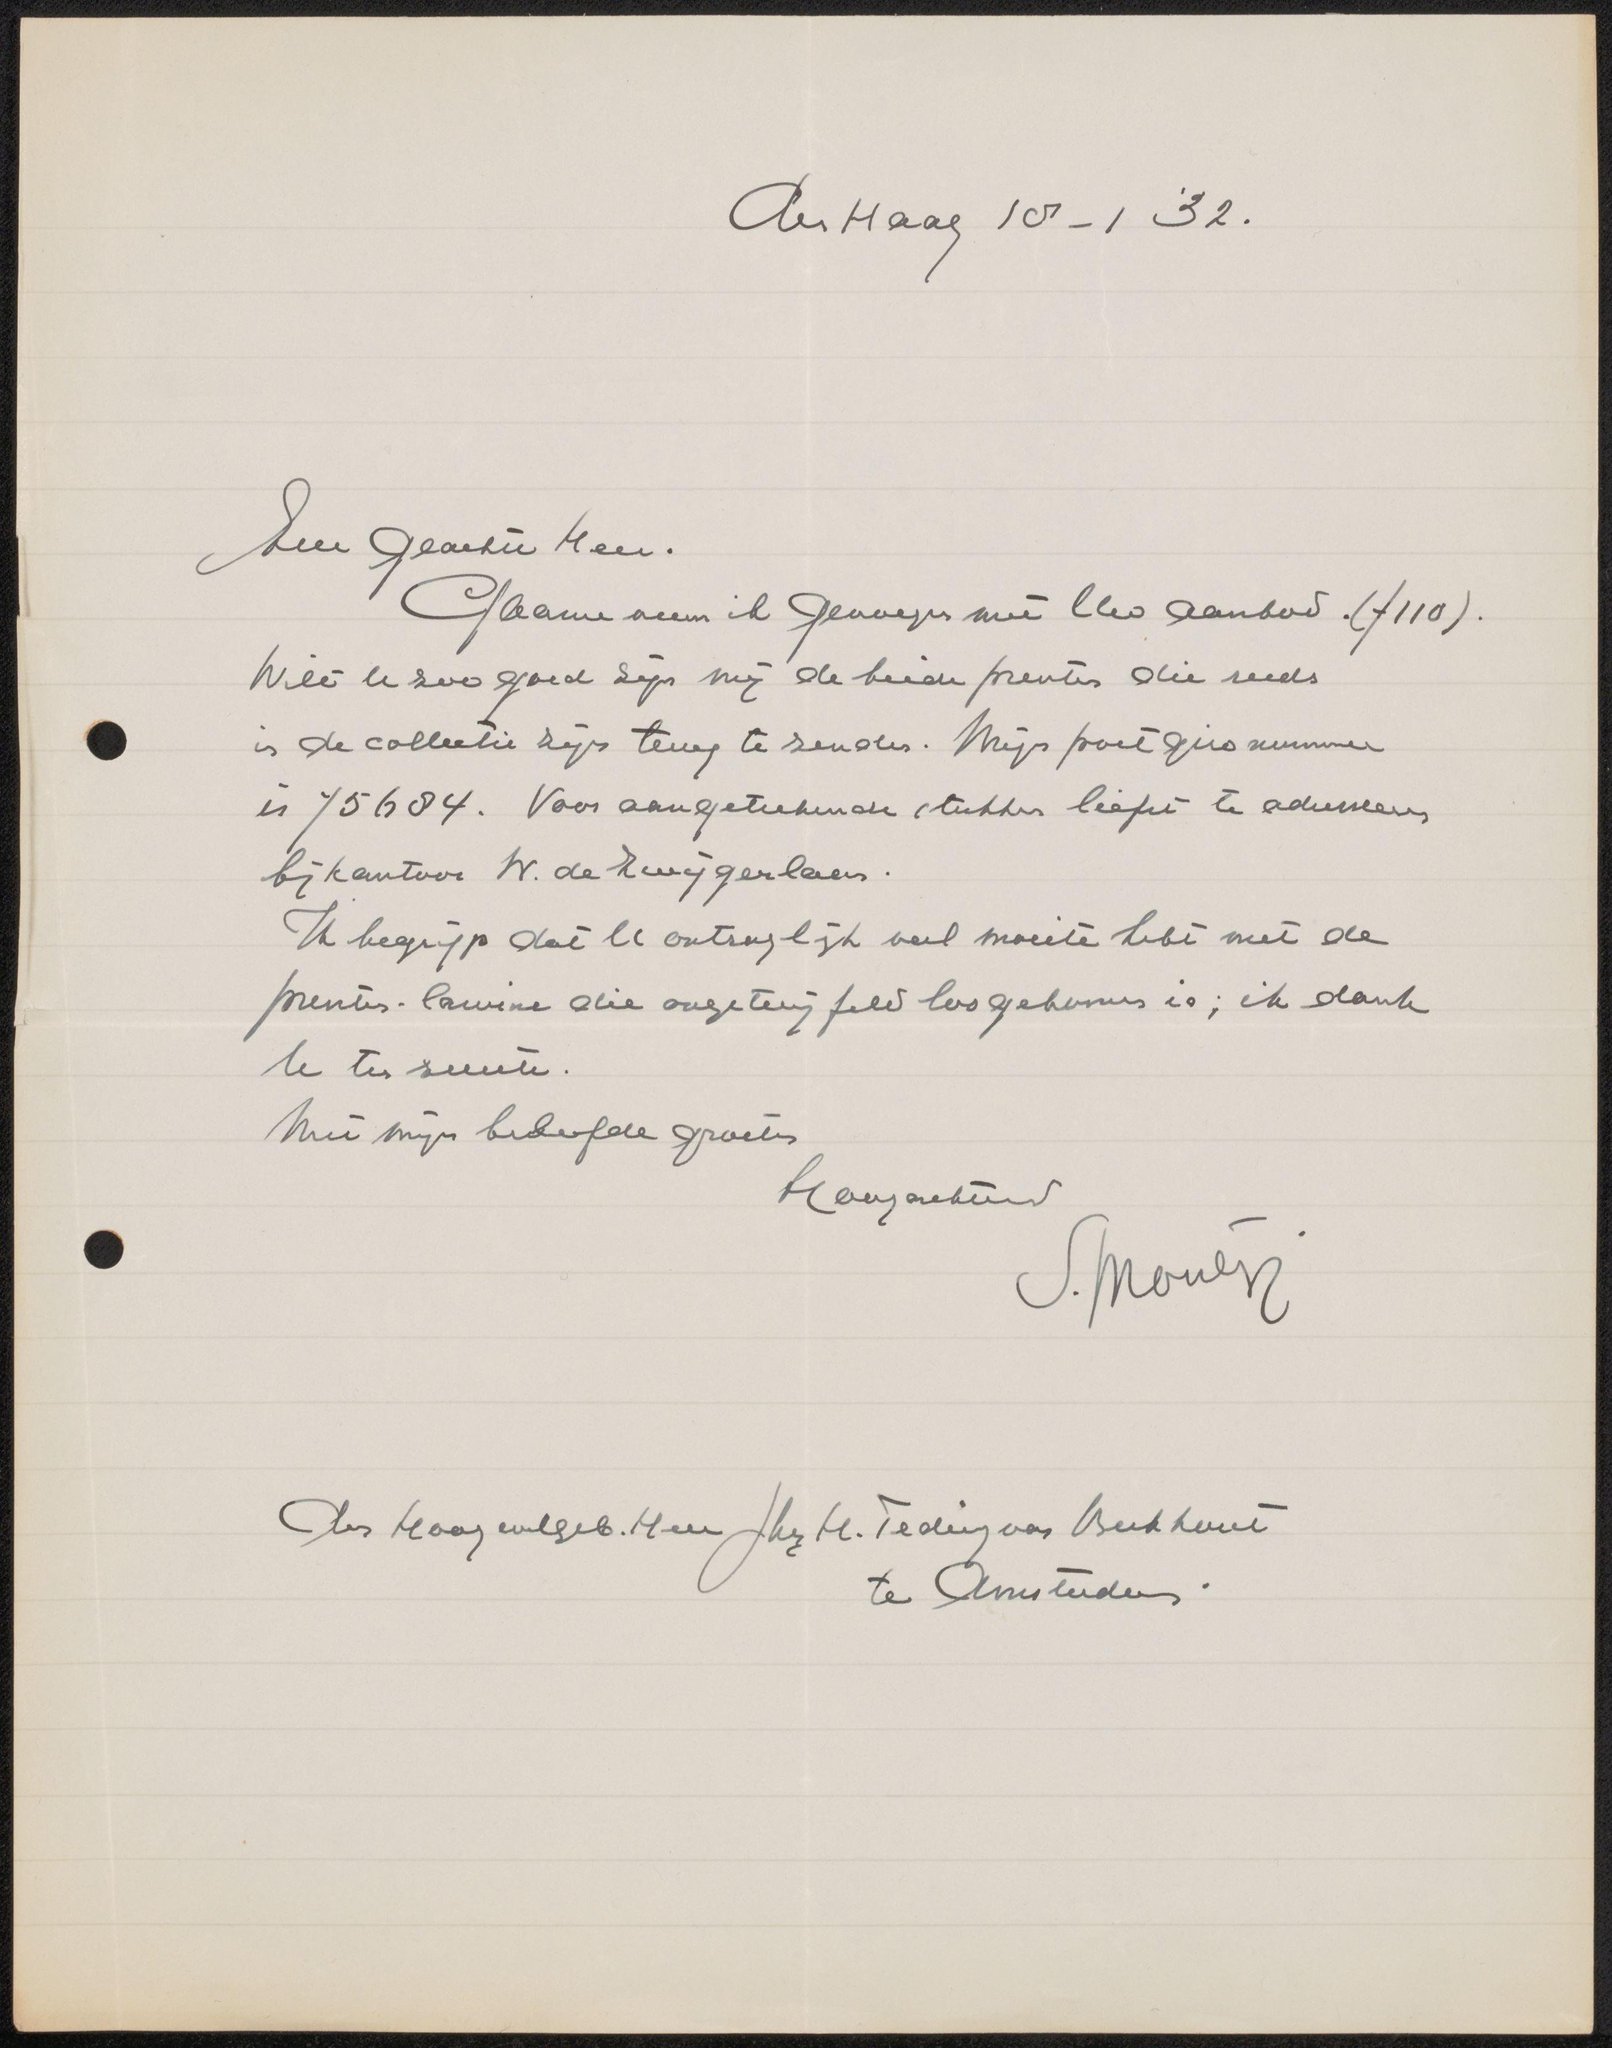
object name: letter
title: Brief aan jonkheer Hendrik Teding van Berkhout (1879-1969)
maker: simon moulijn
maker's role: draughtsman, print maker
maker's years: 1866-1948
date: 1932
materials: ink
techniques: pen, writing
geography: the hague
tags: print room, haarlem, amsterdam, jonkheer hendrik teding van berkhout (1879-1969), the graphic arts, art collecting, money